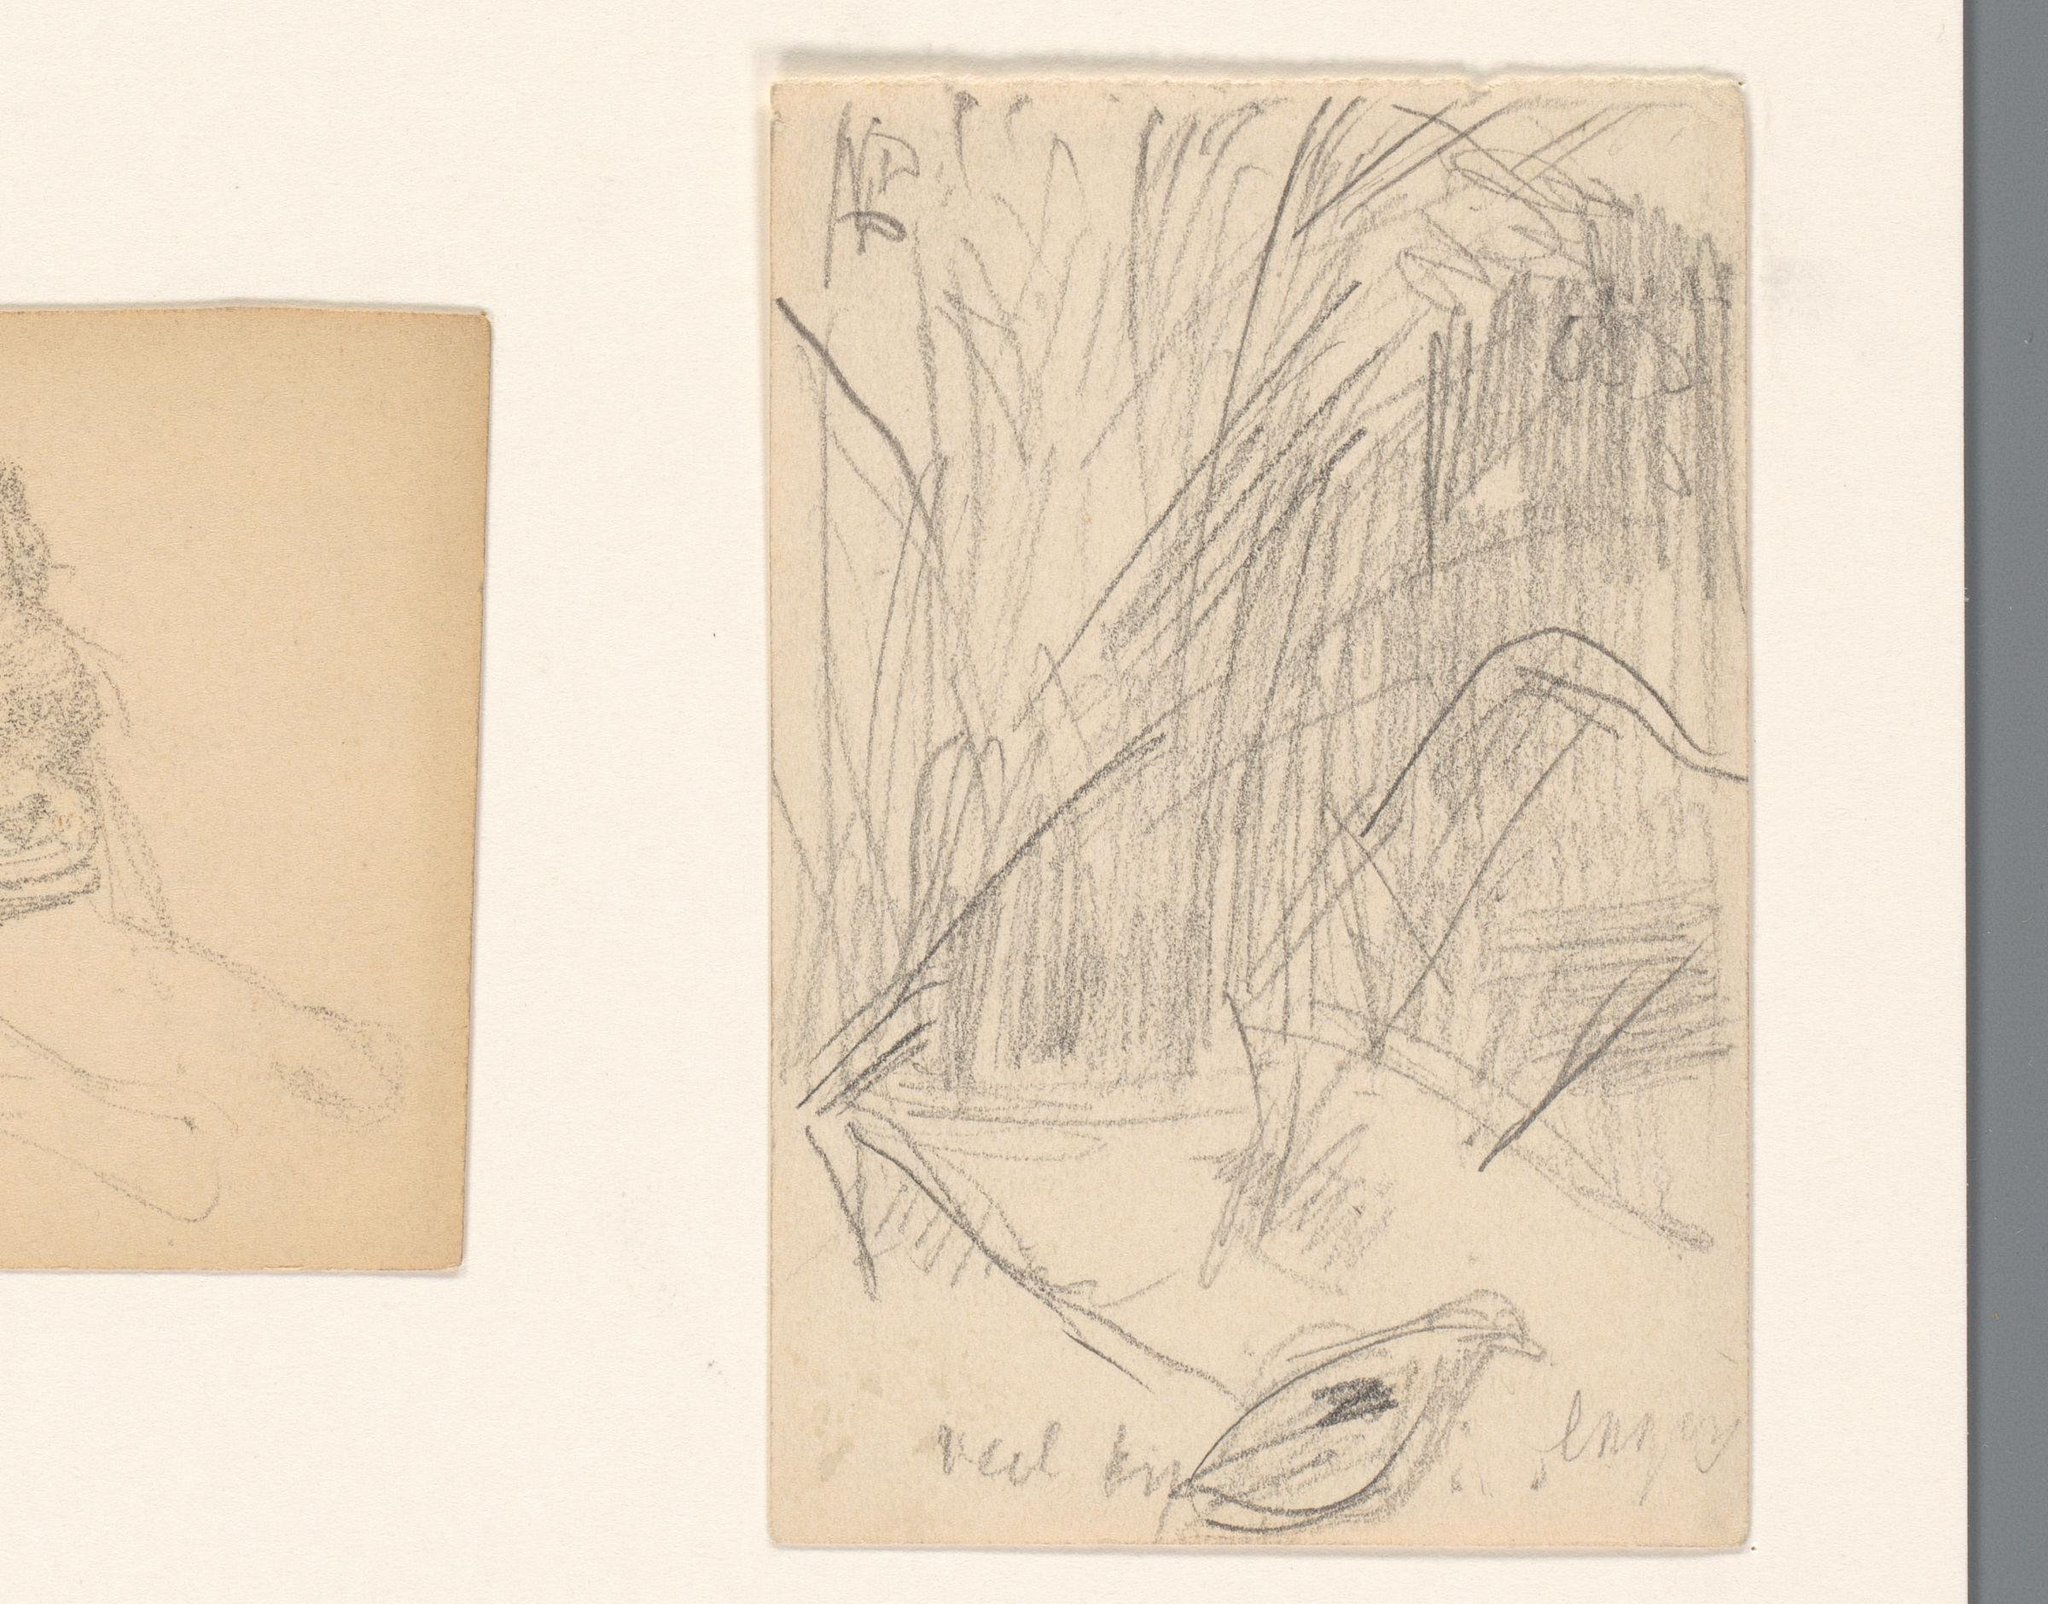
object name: drawing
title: Vogel in een rietkraag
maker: august allebé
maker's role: draughtsman, print maker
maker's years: 1838-1927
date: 1848-1927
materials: paper, pencil